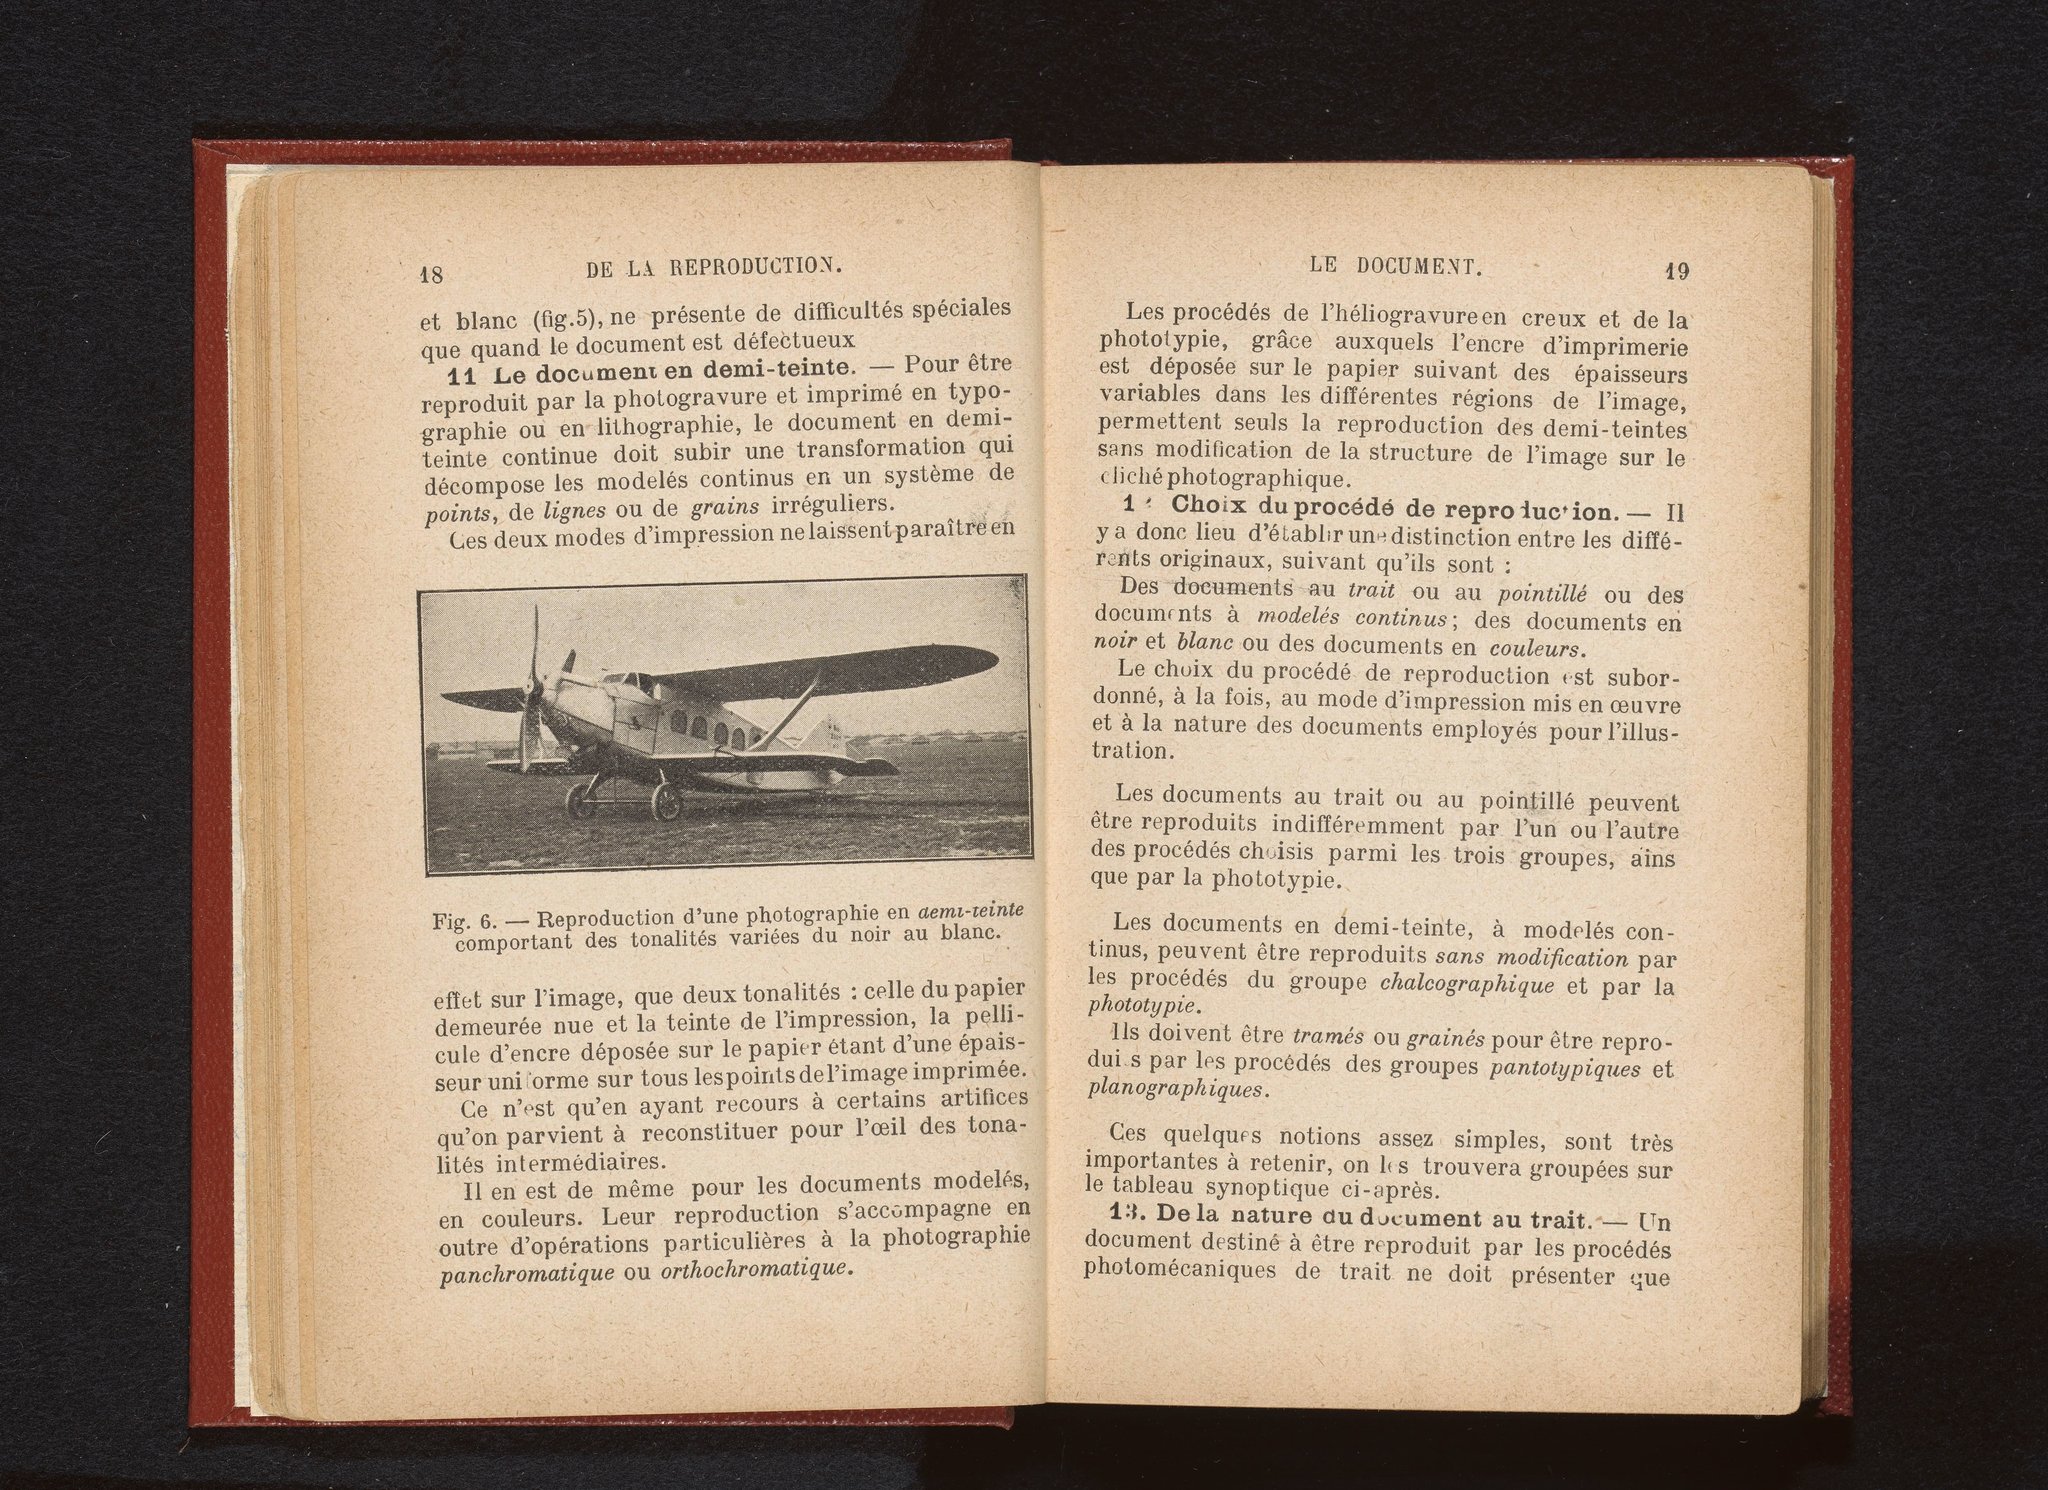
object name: page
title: Vliegtuig aan de grond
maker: Anonymous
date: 1922-1932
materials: paper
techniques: autotype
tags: aircraft, aeroplane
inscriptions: number: ‘Fig. 6.’